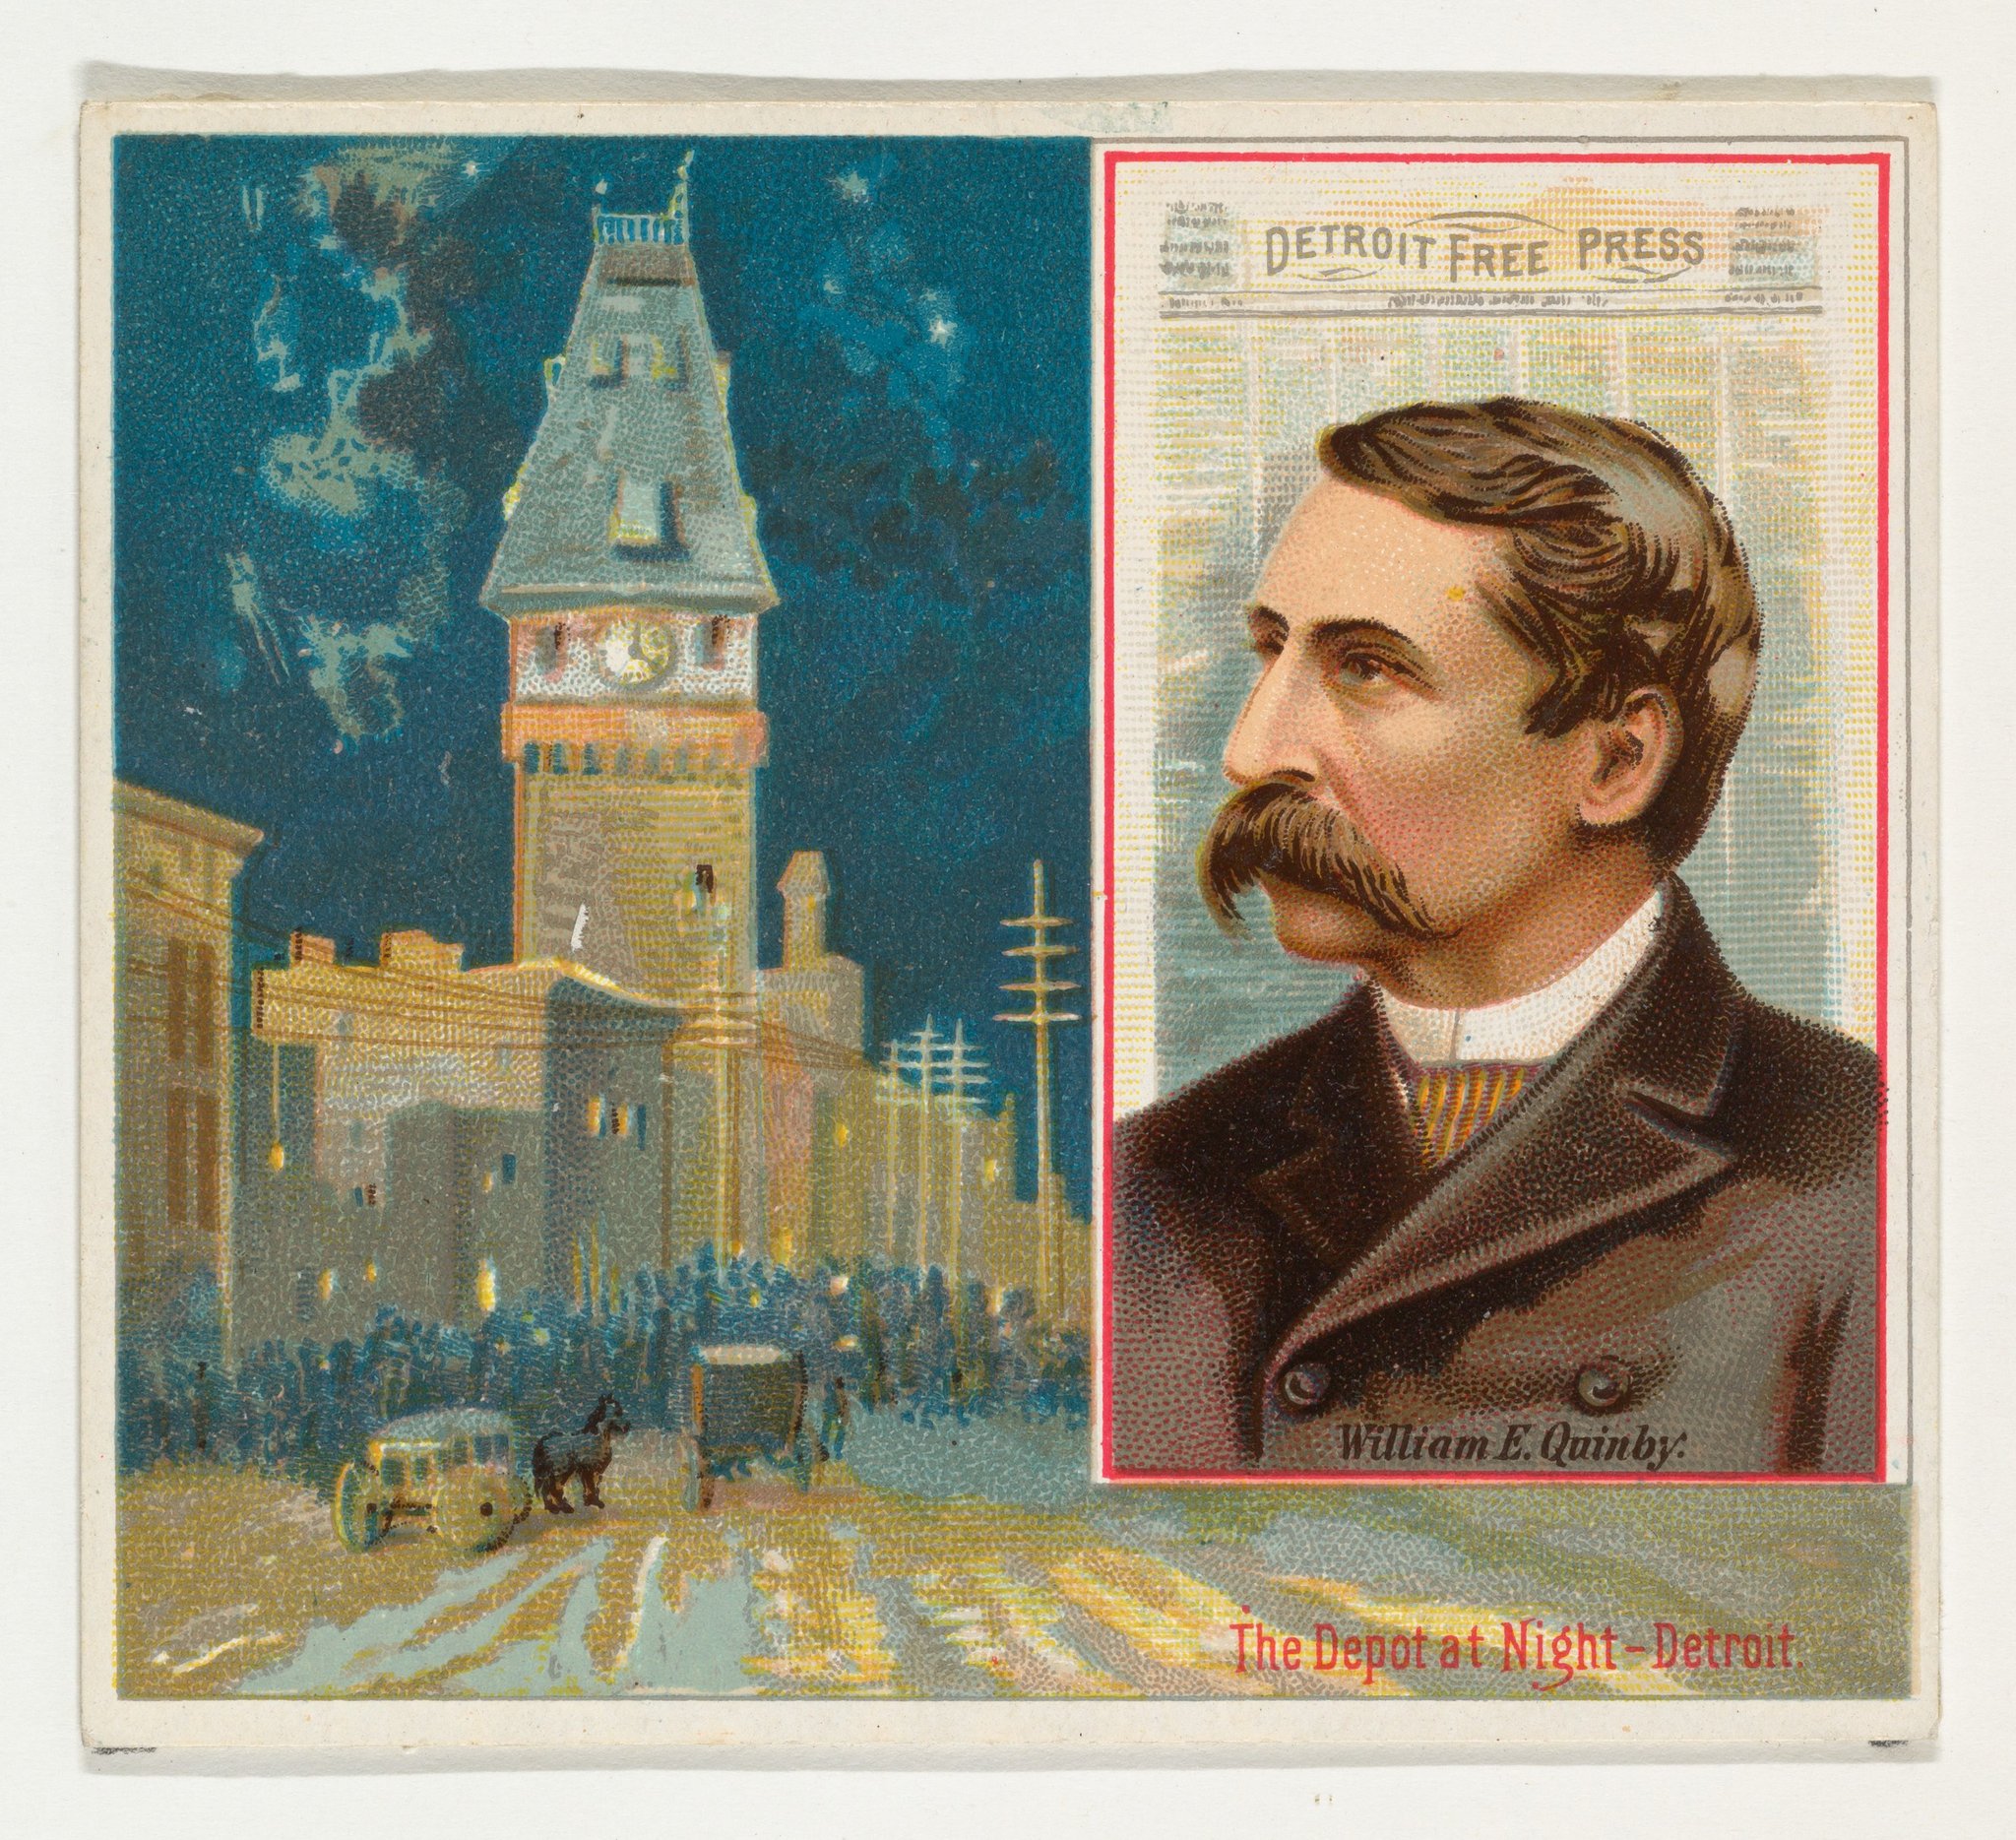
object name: print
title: William E. Quinby, Detroit Free Press, from the American Editors series (N35) for Allen & Ginter Cigarettes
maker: allen & ginter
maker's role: publisher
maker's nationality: american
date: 1887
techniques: color lithograph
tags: towers,men,profiles,carriages